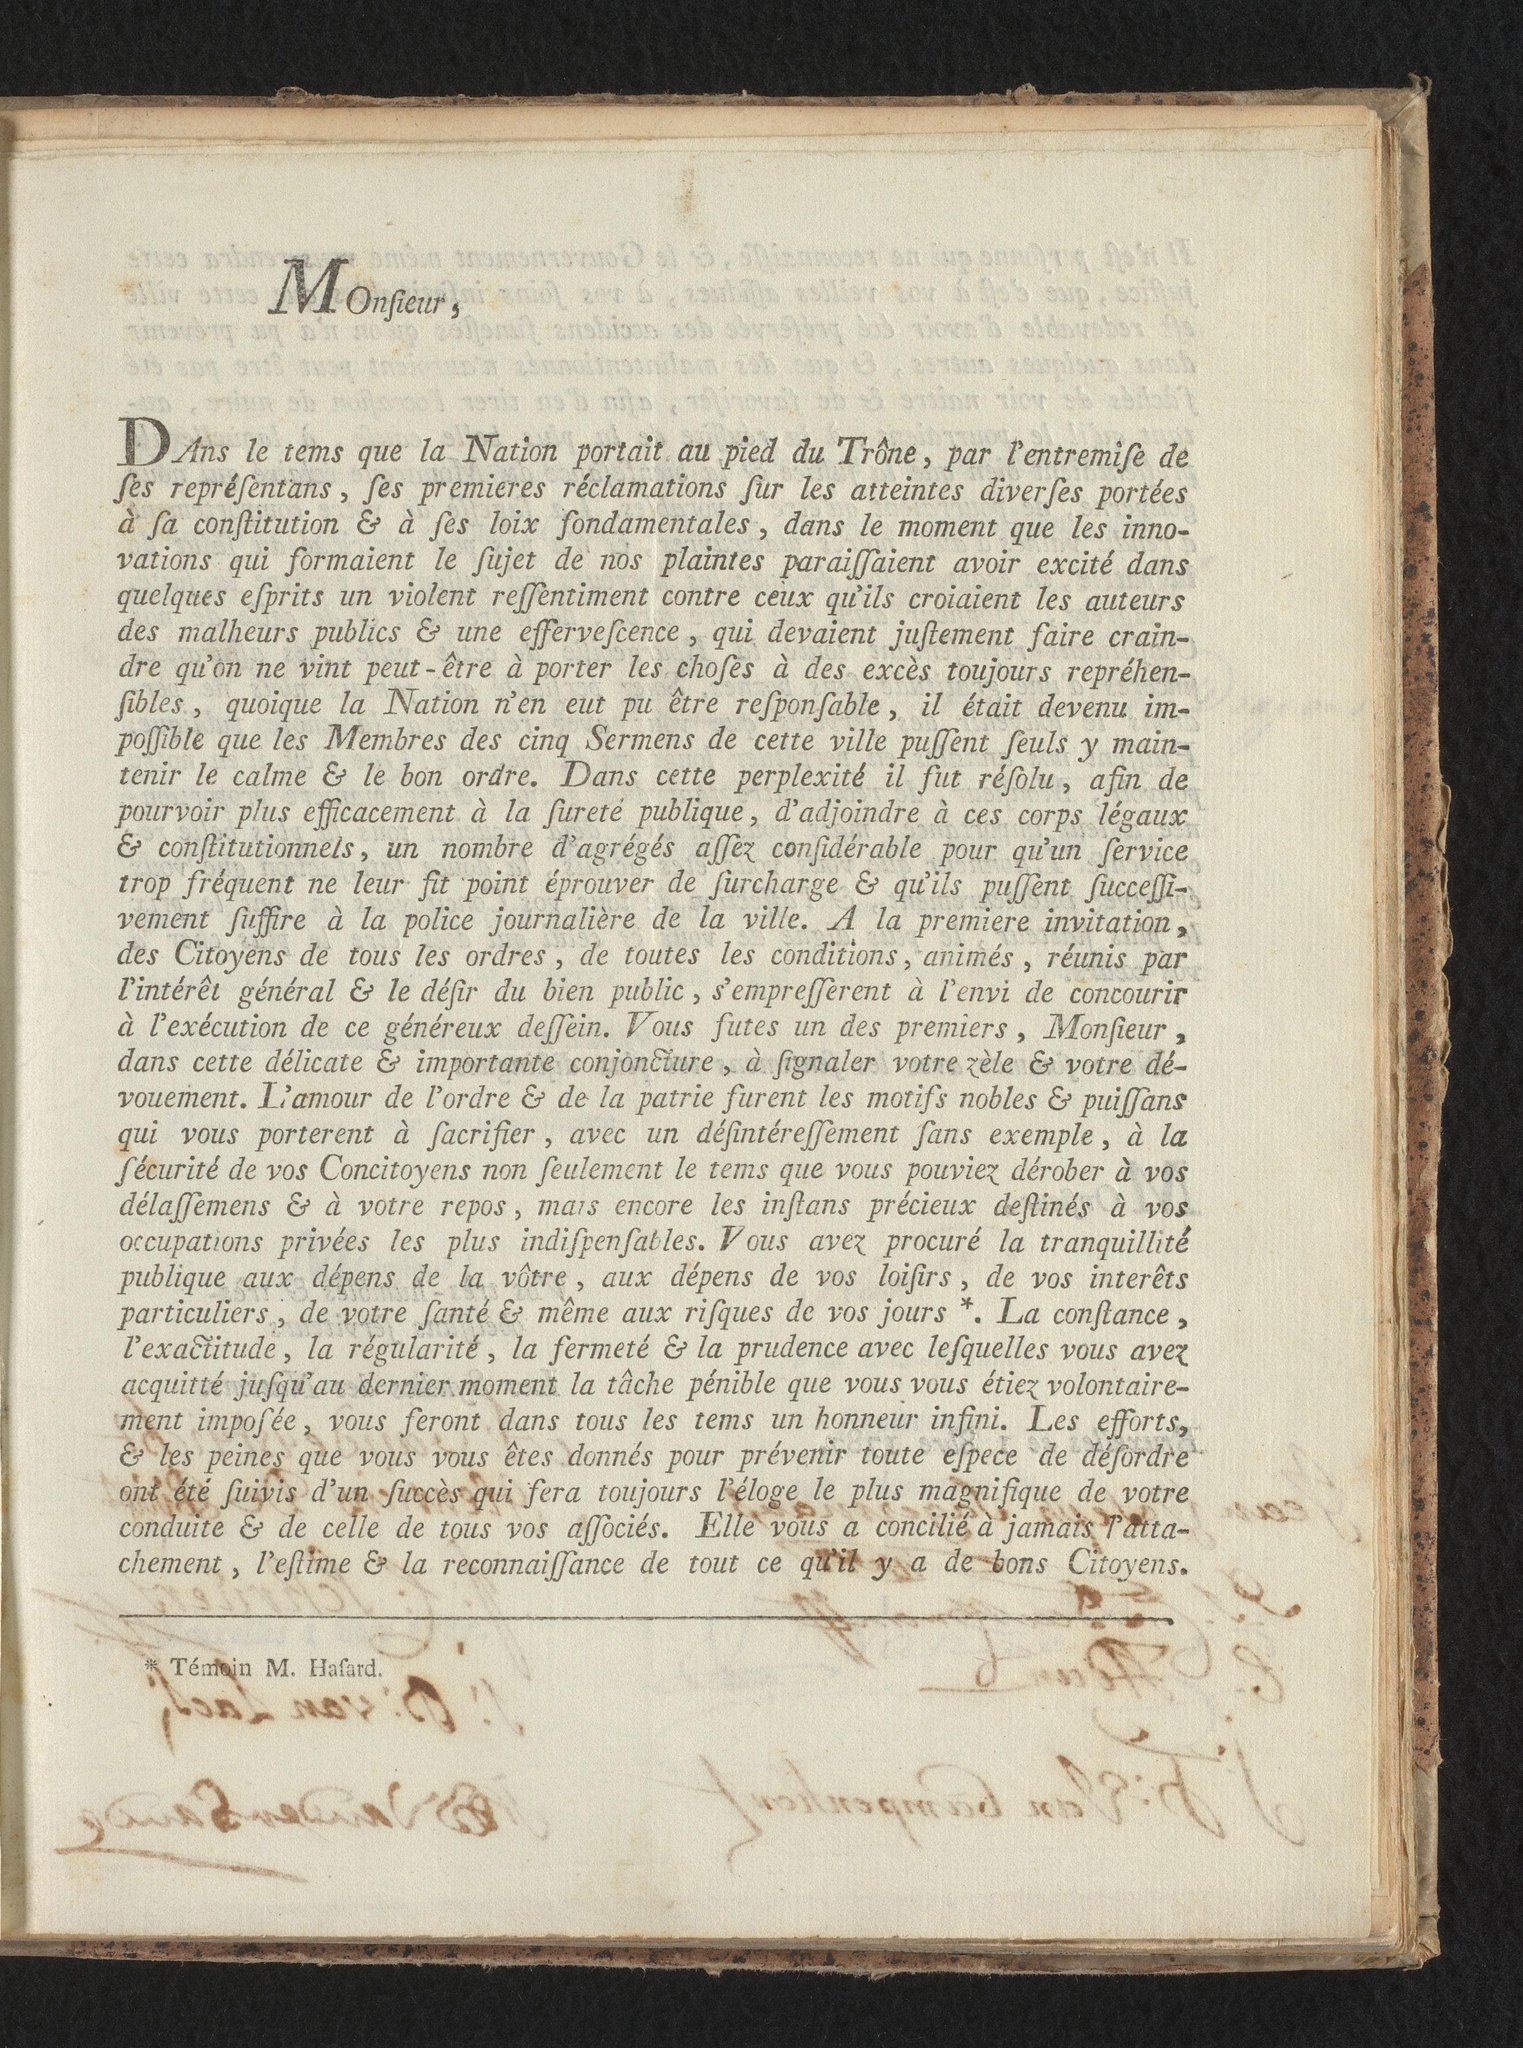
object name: text sheet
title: Gedrukte brief van 1787 (voorzijde)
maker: Anonymous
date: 1787-1790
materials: paper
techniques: letterpress printing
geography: brussels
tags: brabant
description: Voorzijde van een gedrukte brief van 1 augustus 1787 ondertekend door de acht vertegenwoordigers. Onderdeel van de gebundelde verzameling prenten betrekking hebbend op de gebeurtenissen van de Brabantse Omwenteling en de periode 1787-1790.